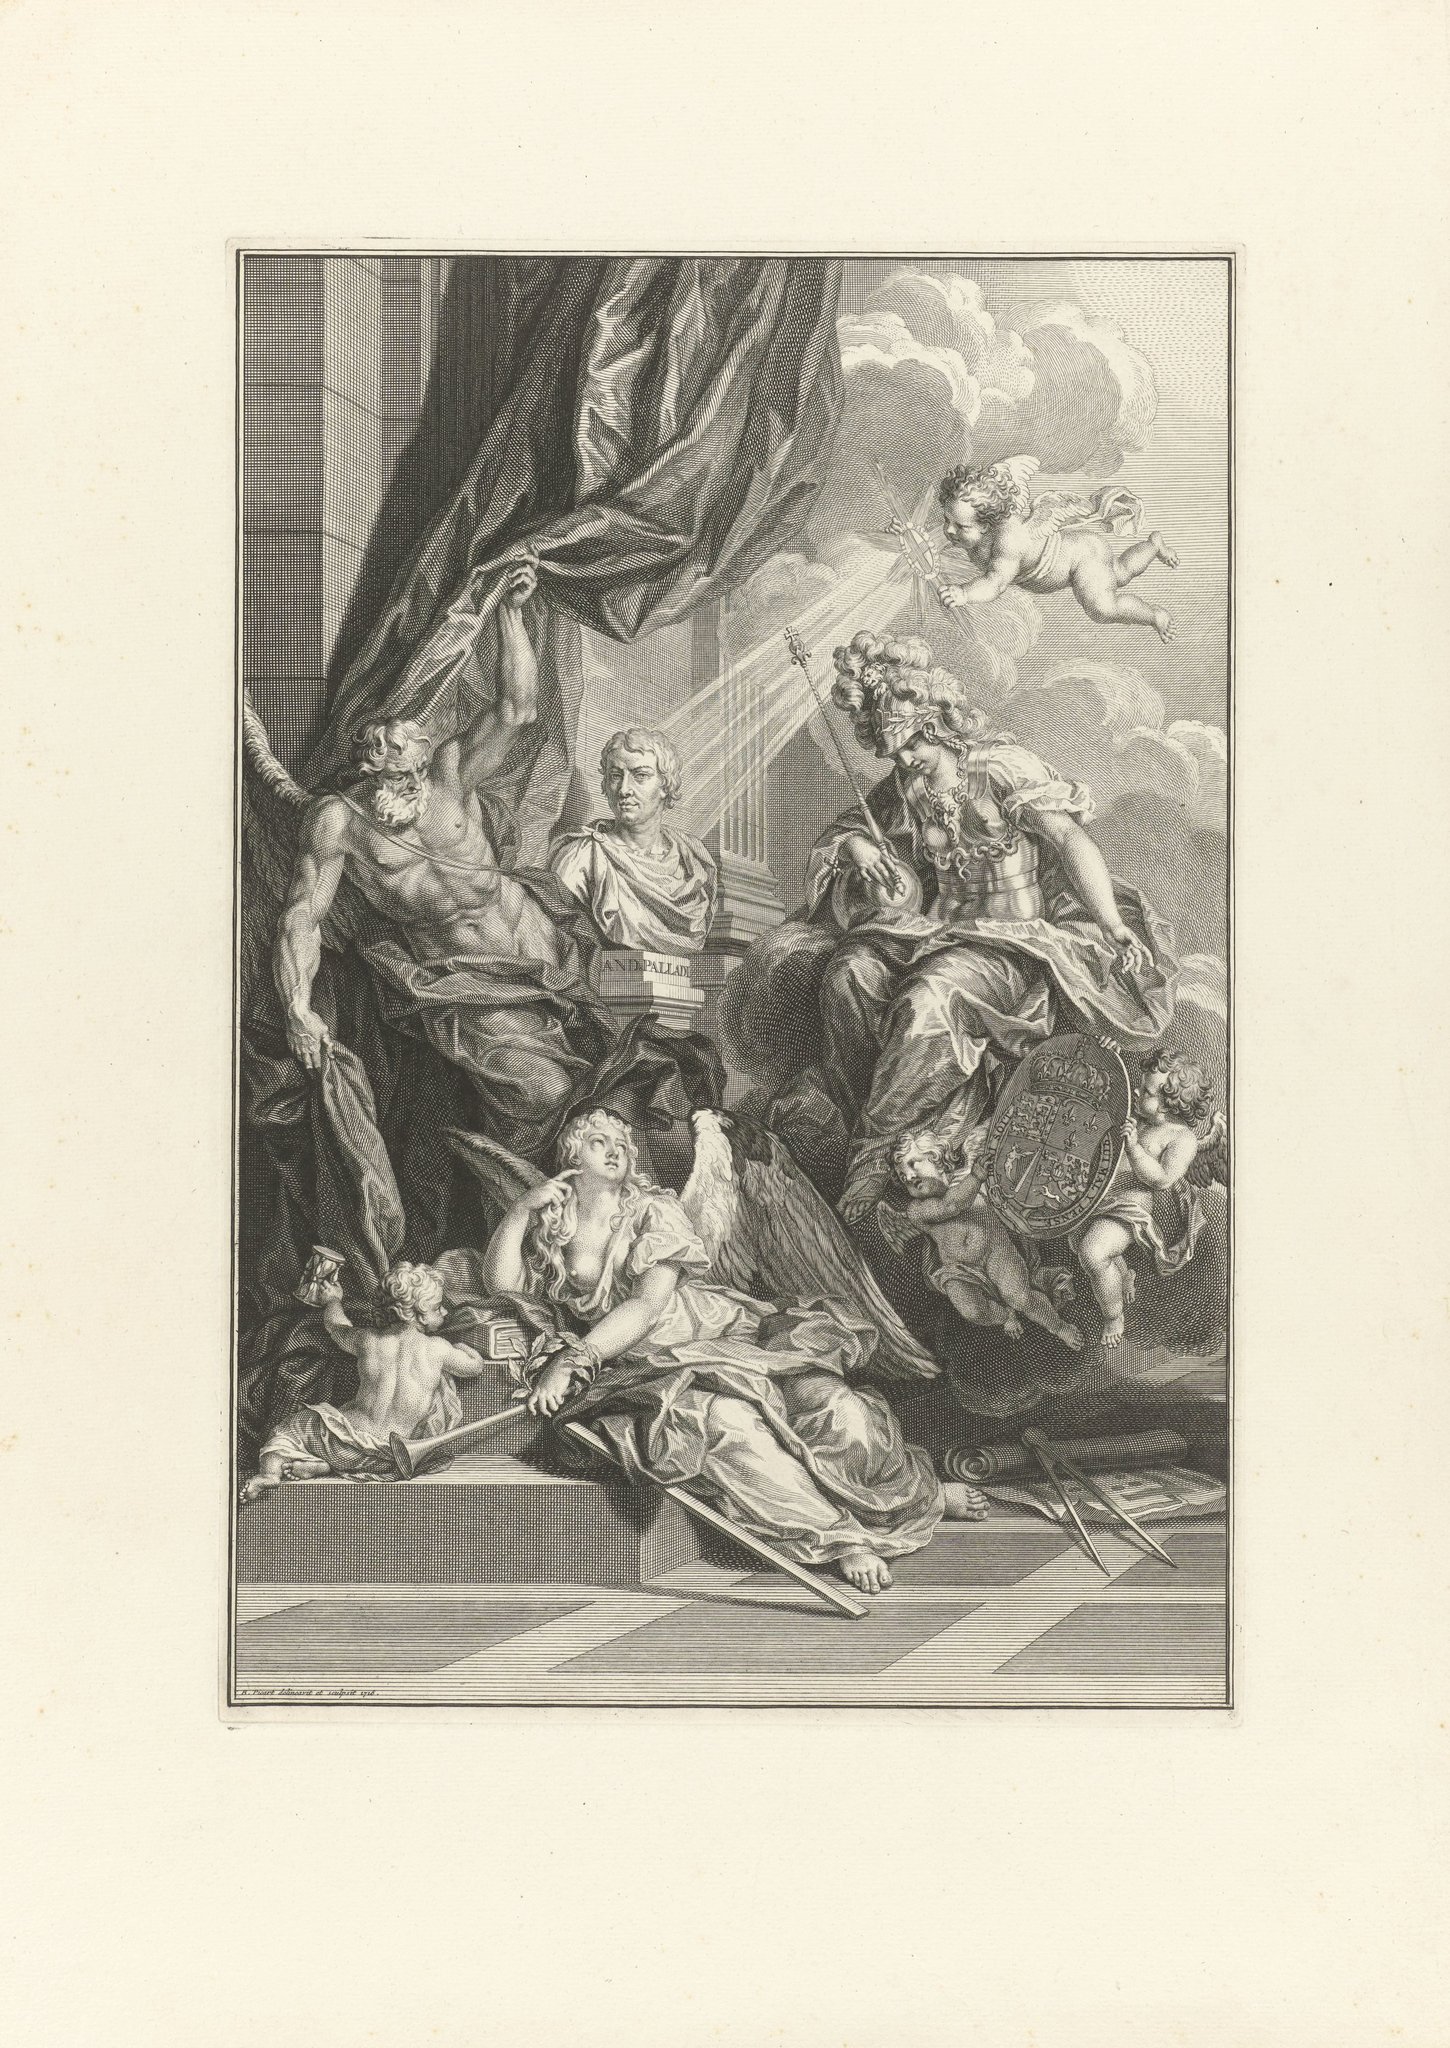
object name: titelblad, titelpagina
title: Portretbuste van Andrea Palladio omgeven door personificaties van Tijd, Faam en Wijsheid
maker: bernard picart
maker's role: draughtsman, print maker, publisher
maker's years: 1673-1733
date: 1716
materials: paper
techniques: engraving, etching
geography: amsterdam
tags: andrea palladio, (story of) minerva (pallas, athena), compasses, fame; 'fama', 'fama buona', 'fama chiara' (ripa), father time, man with wings and scythe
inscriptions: collector's mark: Lugt 2228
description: De portretbuste van de architect Andrea Palladio wordt onthuld door Vader Tijd. Een putto beschijnt de buste met lichtstralen. Op de voorgrond Faam, met een lauwerkrans en bazuin in de handen. Ze kijkt op naar Minerva die wordt vergezeld door twee putti die het wapenschild van koning George I van Engeland omhoog houden. Rechts op de vloer een passer als verwijzing naar het beroep van Palladio.